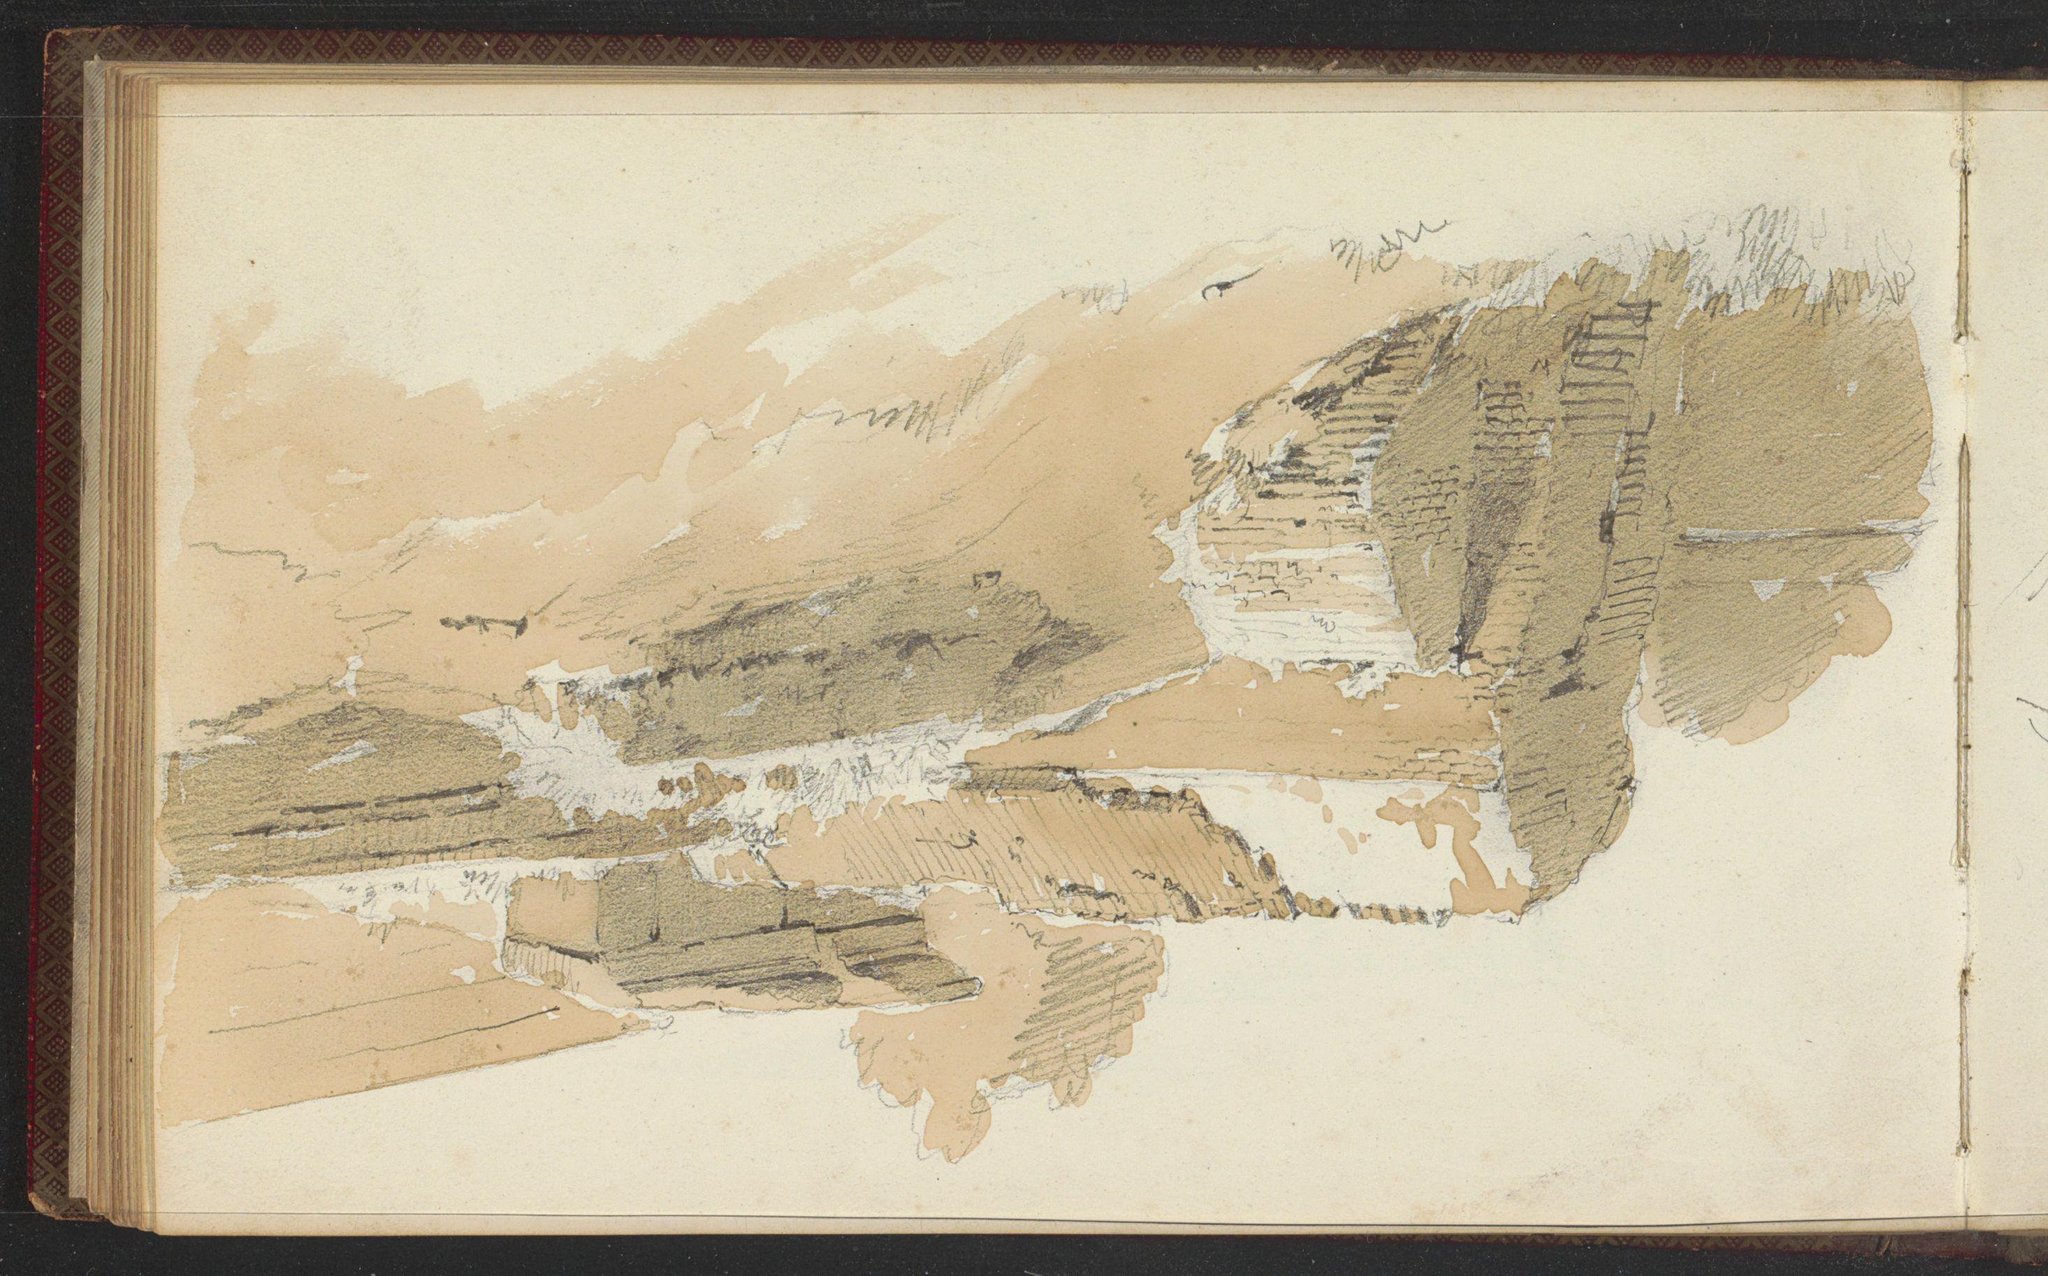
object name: sketchbook leaf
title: Muur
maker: adrianus eversen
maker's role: draughtsman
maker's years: 1818-1897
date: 1828-1897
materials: paper, pencil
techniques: stumping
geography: netherlands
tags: fence, wall, paling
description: Studie van een muur, mogelijk een stadsmuur. Blad 30 verso uit een schetsboek met 52 bladen vervaardigd in de omgeving van Kampen, Hattem, Hoorn en Zwolle.